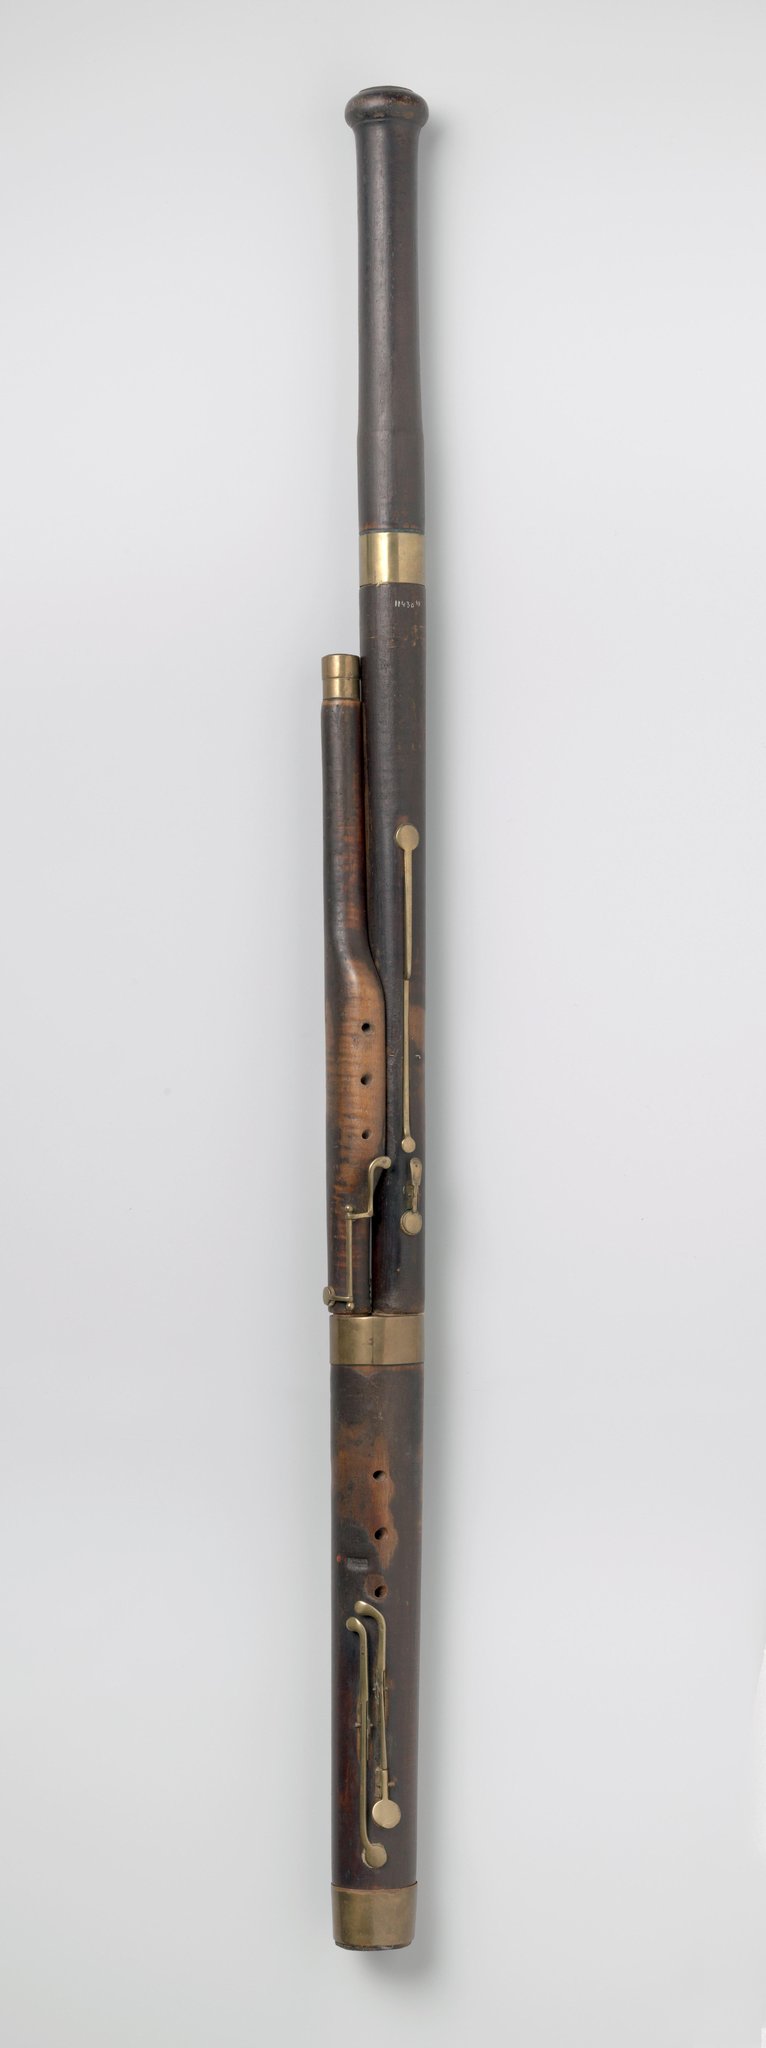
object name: bassoon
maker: august friedrich andreas knochenhauer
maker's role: musical instrument maker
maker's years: 1796-1866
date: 1855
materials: wood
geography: berlin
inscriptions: stamp: ‘Knochenhauer/ Berlin […]’